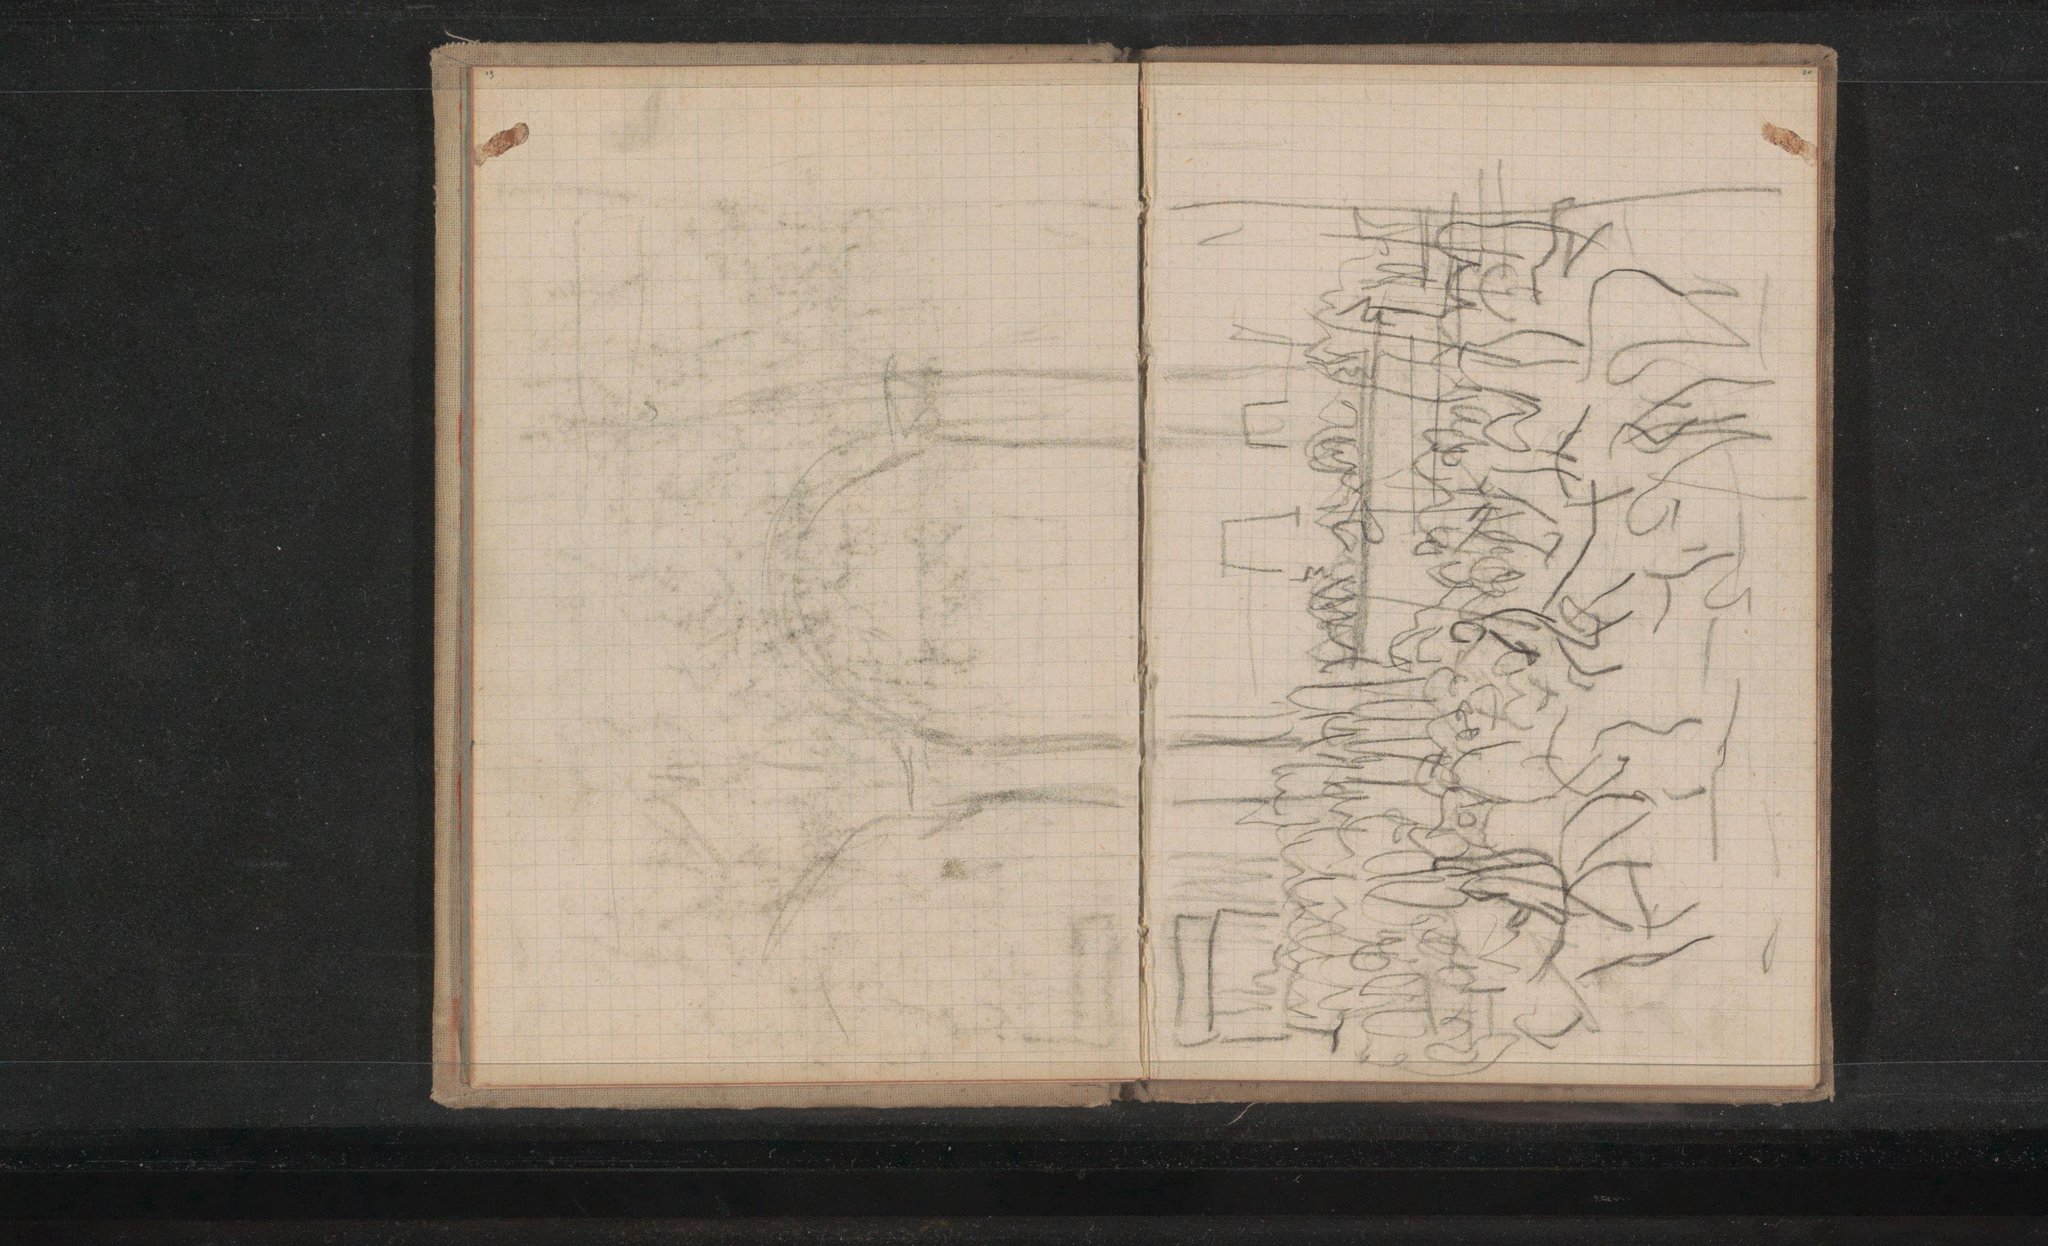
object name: sketchbook leaf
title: Optocht van ruiters bij een zuilengalerij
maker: marius bauer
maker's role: draughtsman, print maker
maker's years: 1867-1932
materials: chalk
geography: istanbul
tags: riding a horse, ass, or mule; rider, horseman, colonnade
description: Pagina 19 en 20 uit een schetsboek met 51 bladen.